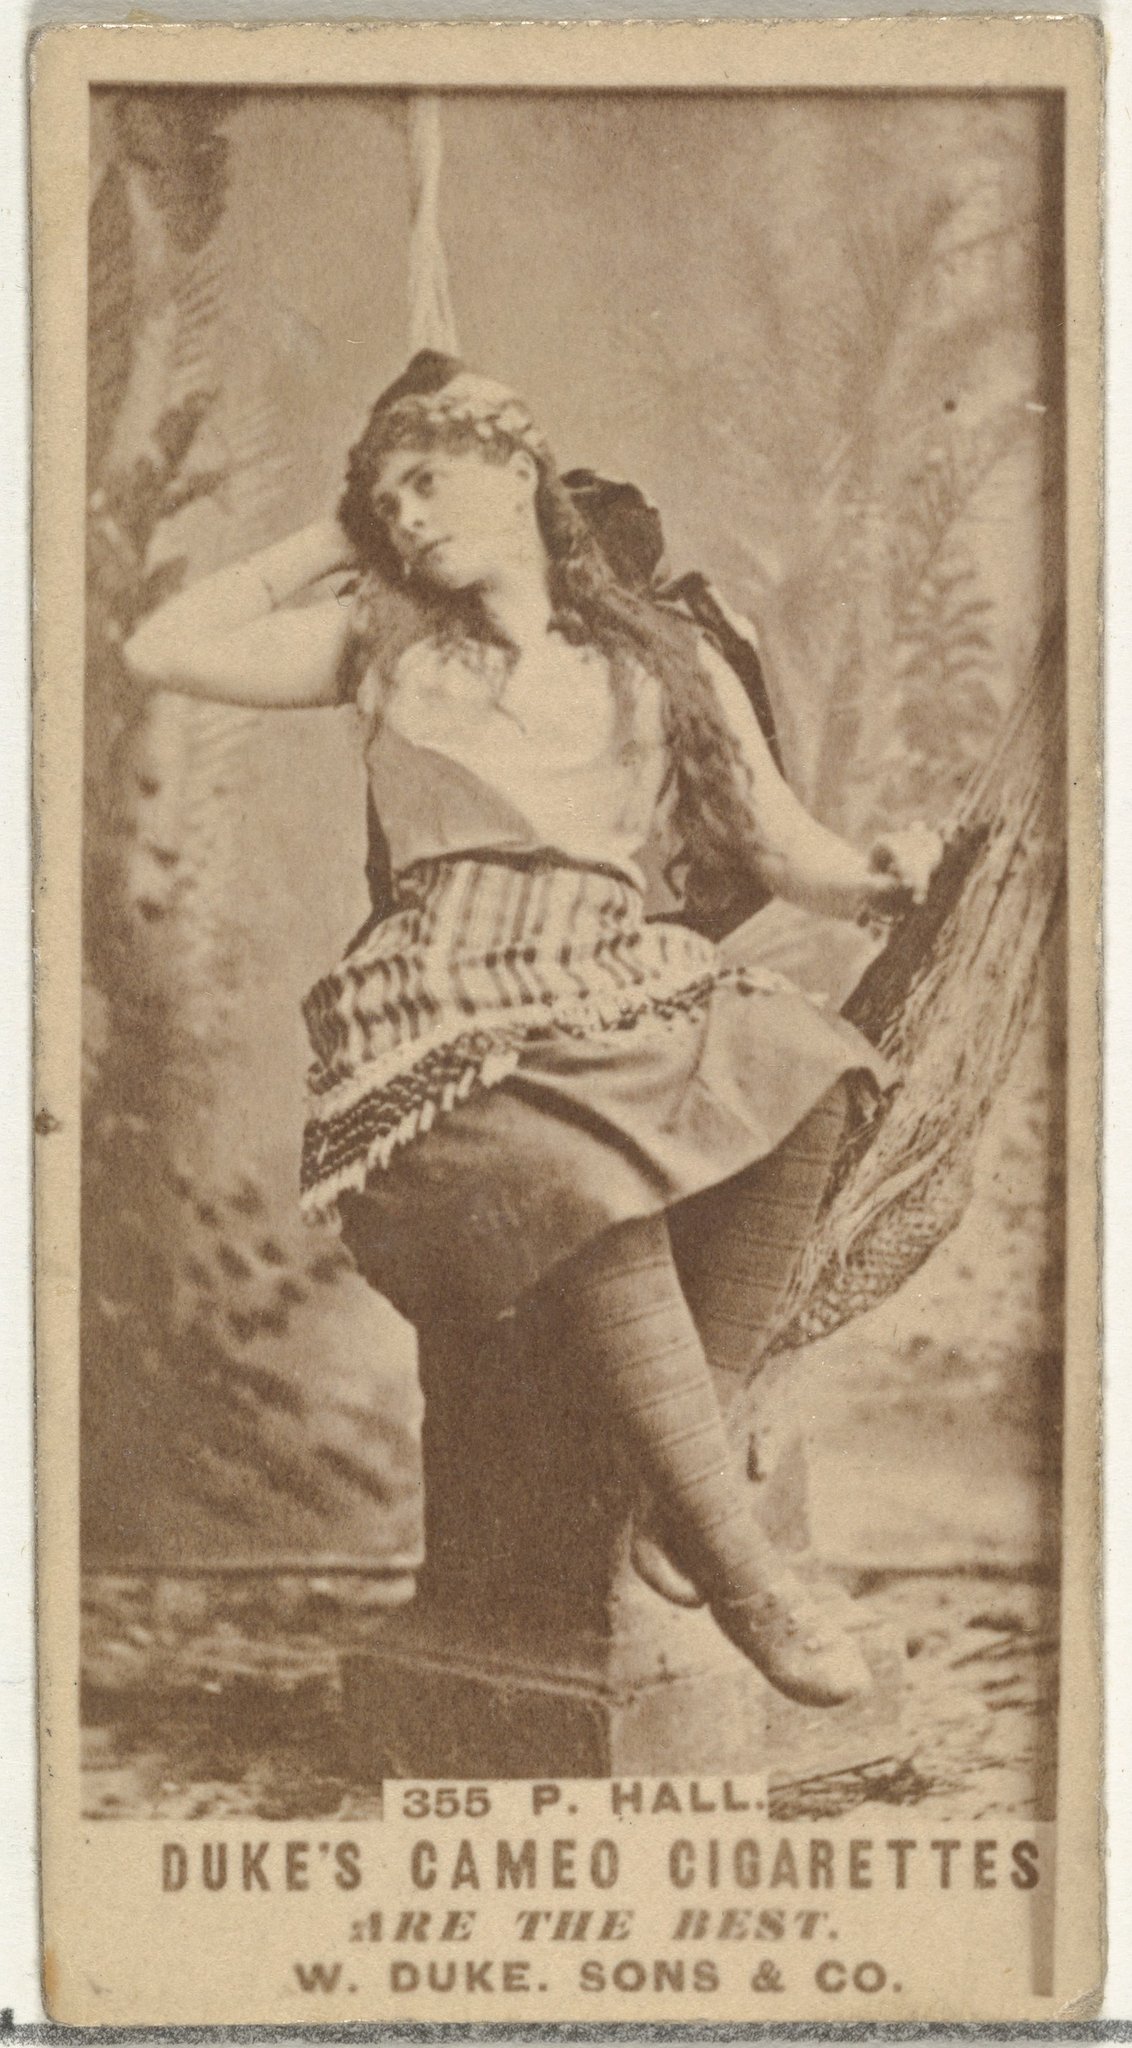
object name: photograph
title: Card Number 355, Pauline Hall, from the Actors and Actresses series (N145-5) issued by Duke Sons & Co. to promote Cameo Cigarettes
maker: w. duke, sons & co.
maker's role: publisher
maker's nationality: american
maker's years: 1870-1920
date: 1880-1889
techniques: albumen silver print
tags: portraits,women,actresses